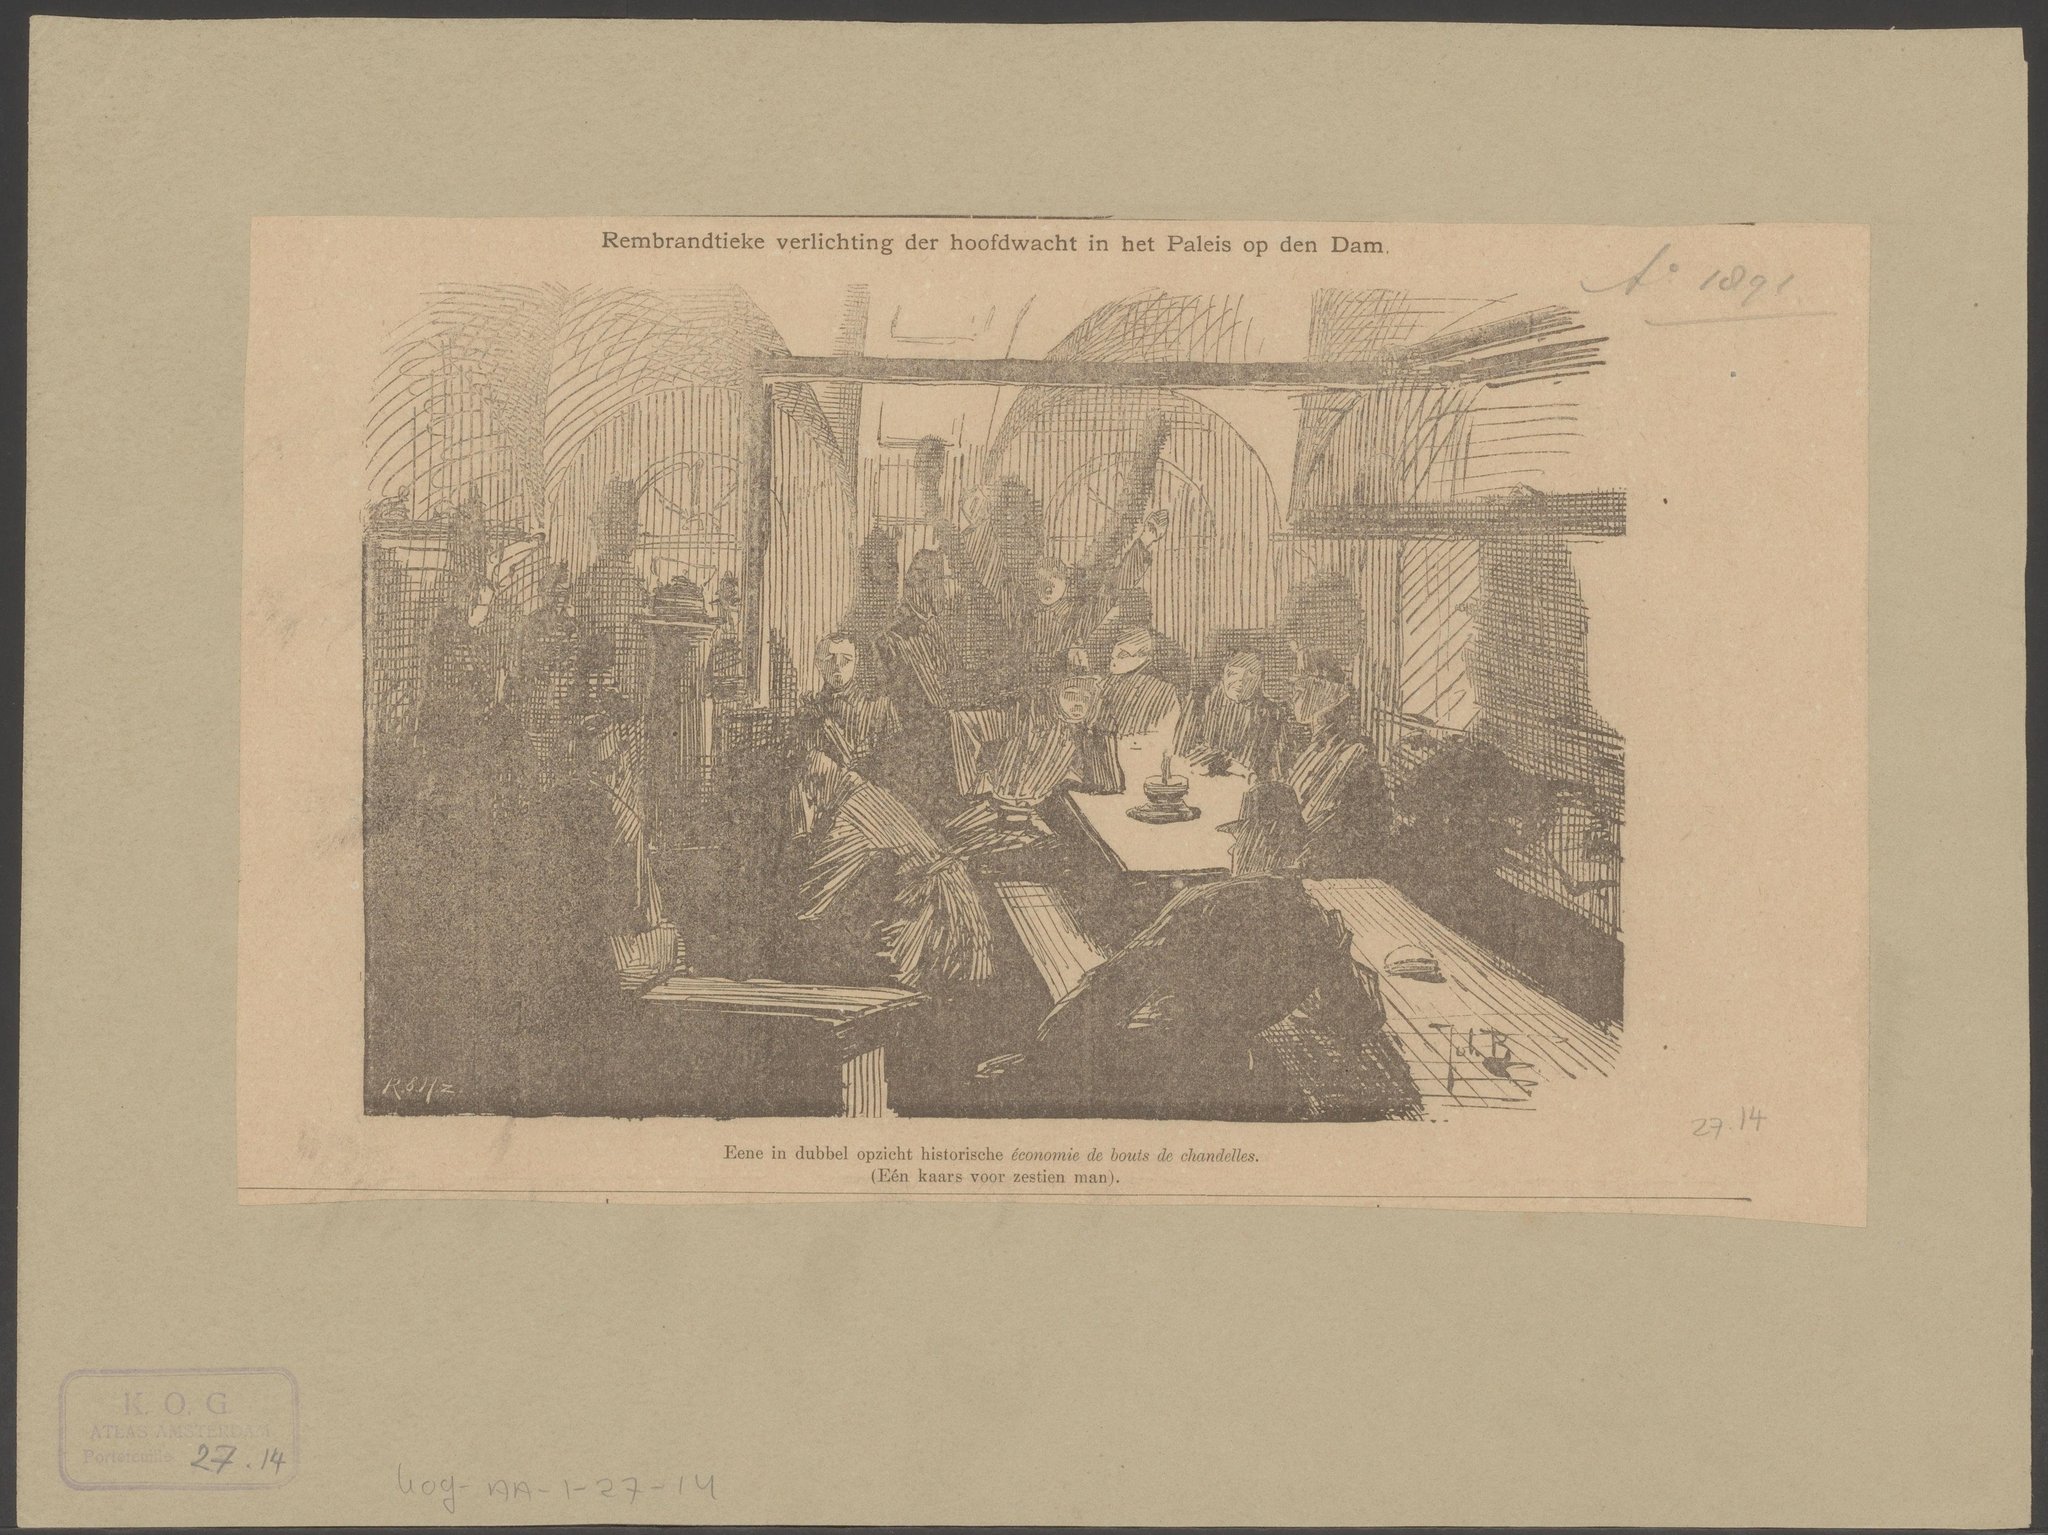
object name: photomechanical print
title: Rembrandtieke verlichting der hoofdwacht in het Paleis op den Dam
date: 1892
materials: paper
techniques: letterpress printing, line block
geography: netherlands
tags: candle, the soldier; the soldier's life, royal palace of amsterdam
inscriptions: signature: ‘R&Hz.’, collector's mark: Lugt 1641b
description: Onderwerpsrubriek binnen de Atlas Amsterdam: Landmacht: Gebouwen / Herinneringen aan officieren, stadssoldaten / Nationale militie / (diverse korpsen) / Padvinders / Parade.